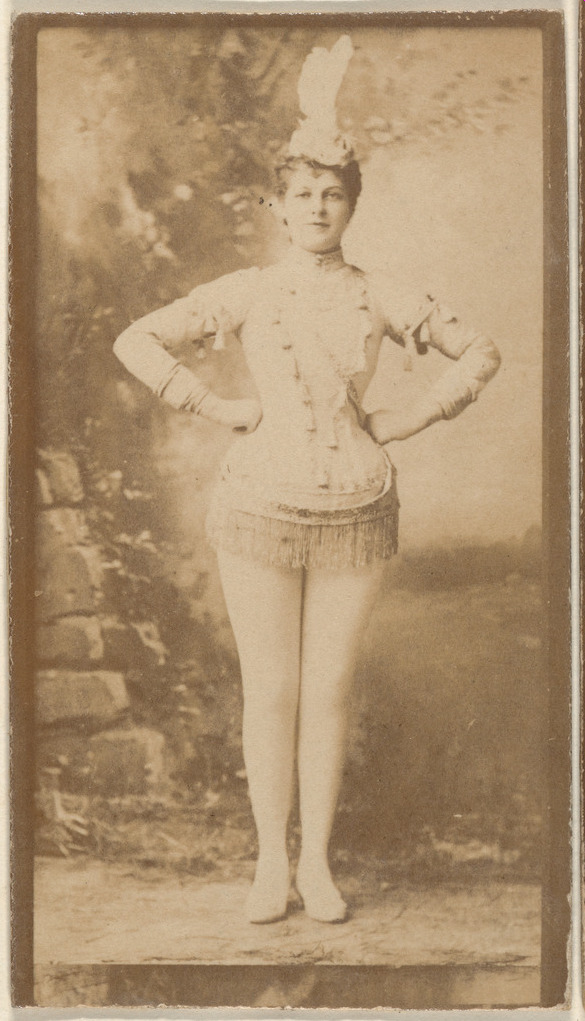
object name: photograph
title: Actress standing with hands on hips, from the Actresses series (N668)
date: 1888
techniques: albumen silver print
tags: portraits,women,actresses